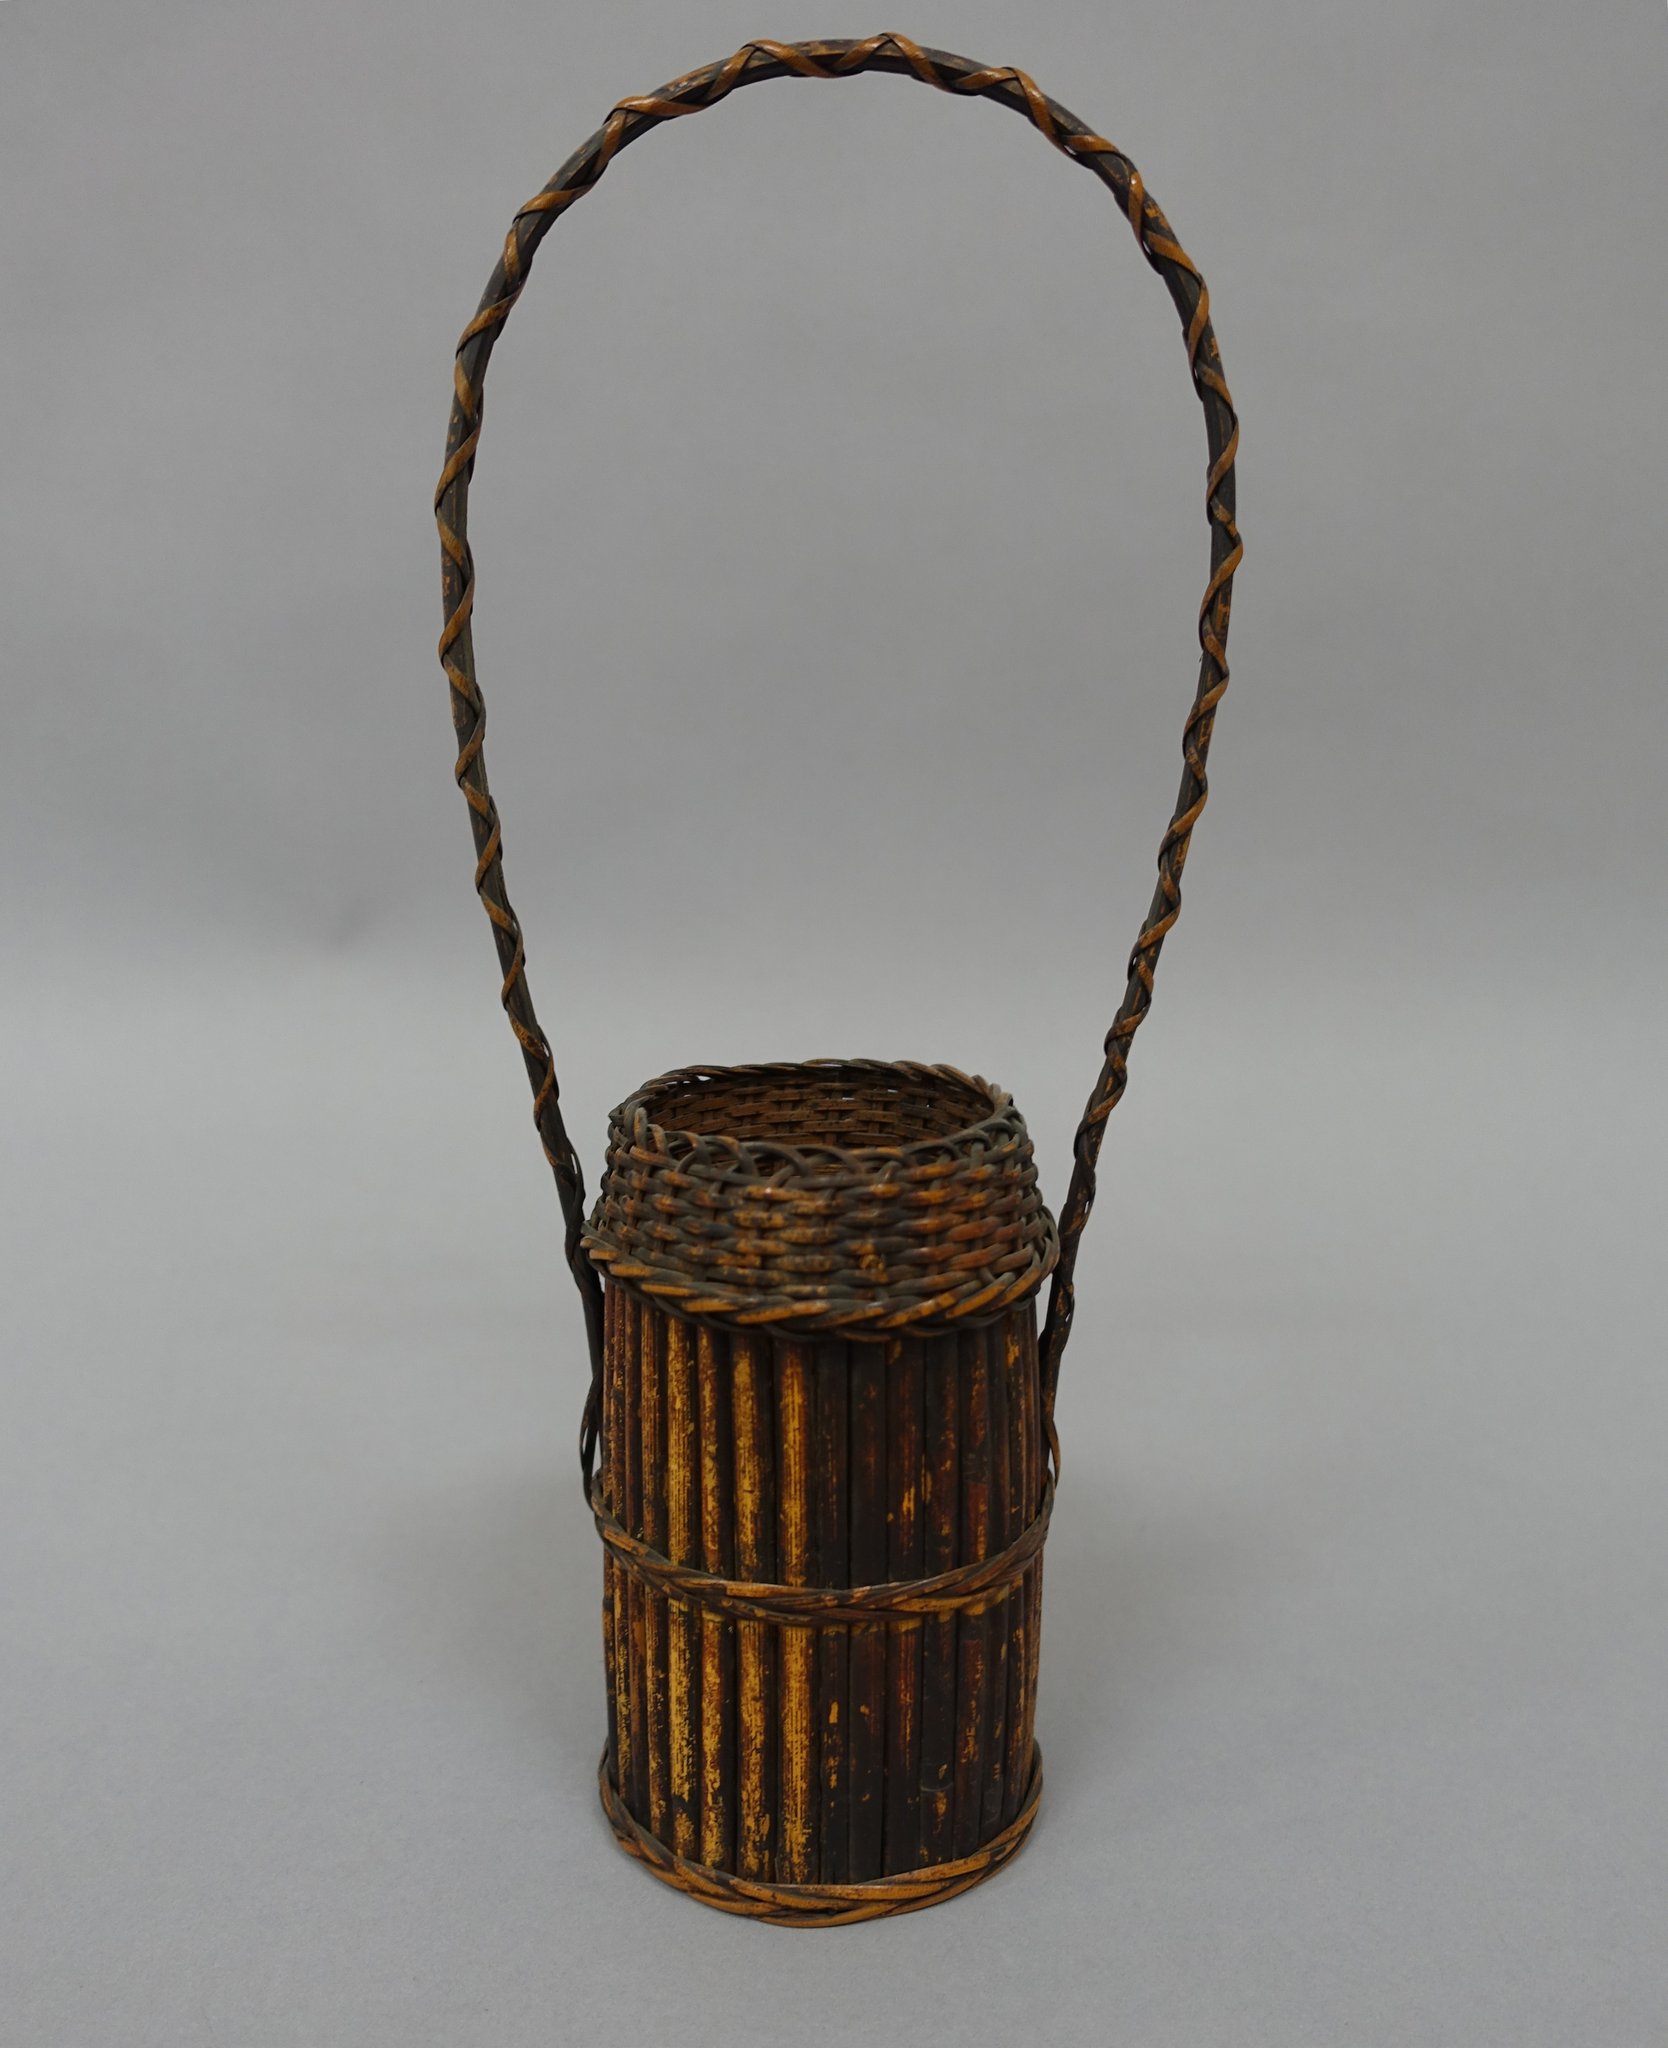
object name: basket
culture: japanese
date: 1801-1900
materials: bamboo